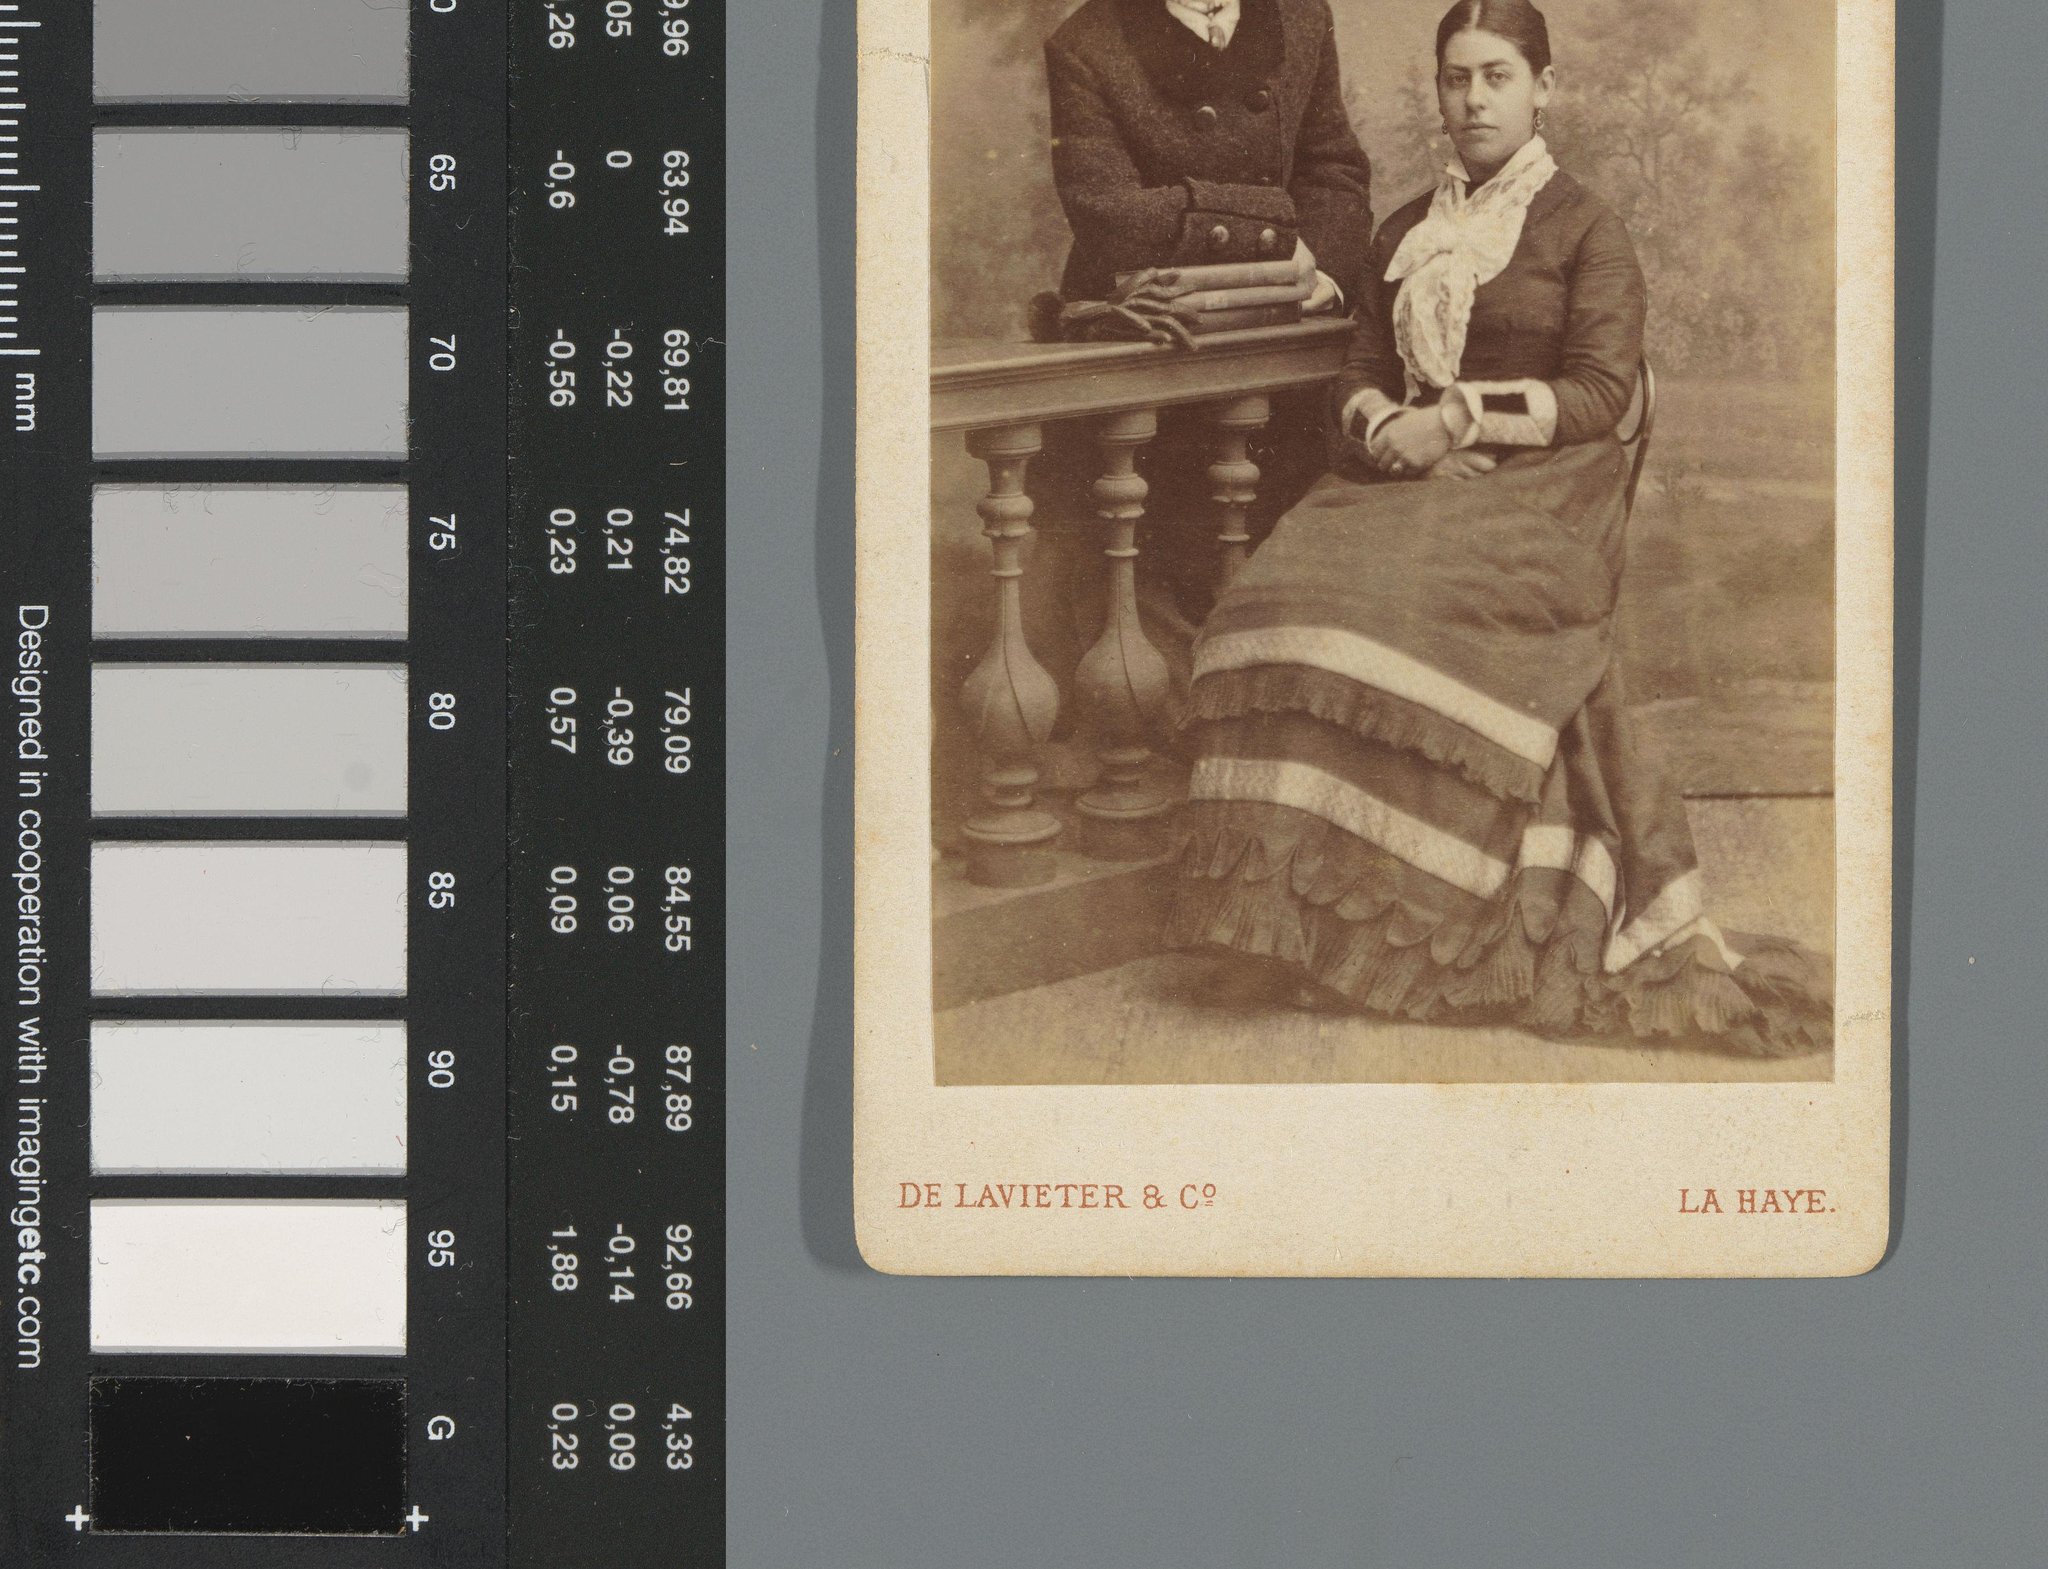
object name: carte de visite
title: Portret van de zusters Susanna Jacoba Hermina en Anna des Tombe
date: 1870-1890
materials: cardboard, photographic support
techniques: photography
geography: the hague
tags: haarlem, historical persons - bb - woman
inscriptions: annotation: ‘SJH des Tombe en A. des Tombe (zittend) (zusters)’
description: Portret van de zusters Susanna Jacoba Hermina (staand) en Maria Cecile Andrea Anna (zittend) des Tombe.